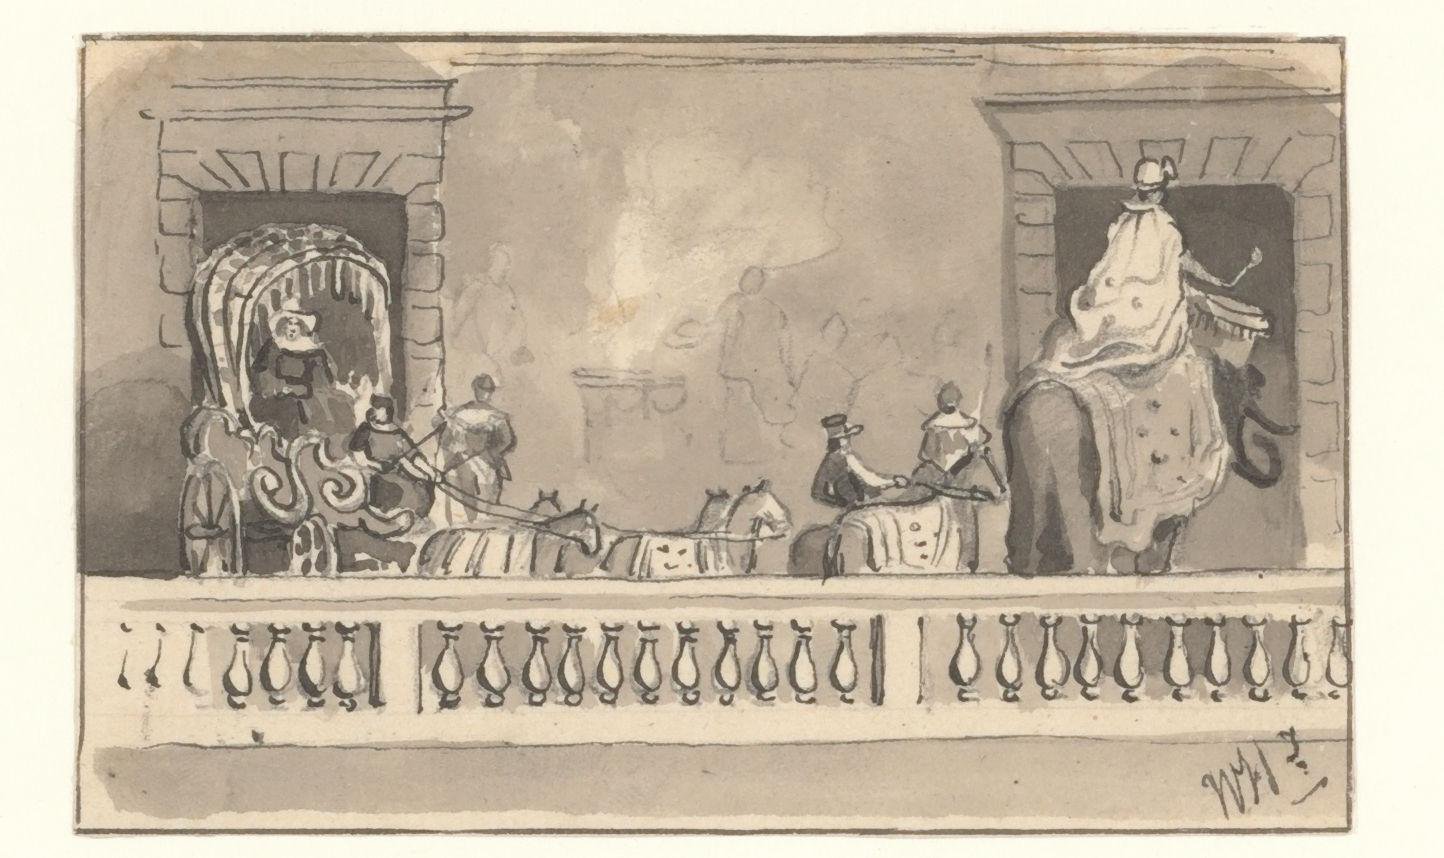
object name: drawing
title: Compositie met beelden in de Beeldenzaal in het Oude Doolhof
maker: willem hekking jr.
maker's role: print maker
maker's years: 1825-1904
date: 1835-1904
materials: ink, paper, pencil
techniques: brush, pen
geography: amsterdam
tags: gallery of sculptures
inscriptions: signature: ‘WHj.’, collector's mark: Lugt 800a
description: Tekening binnen de Atlas Van Eck ingedeeld op wijknummer 18.